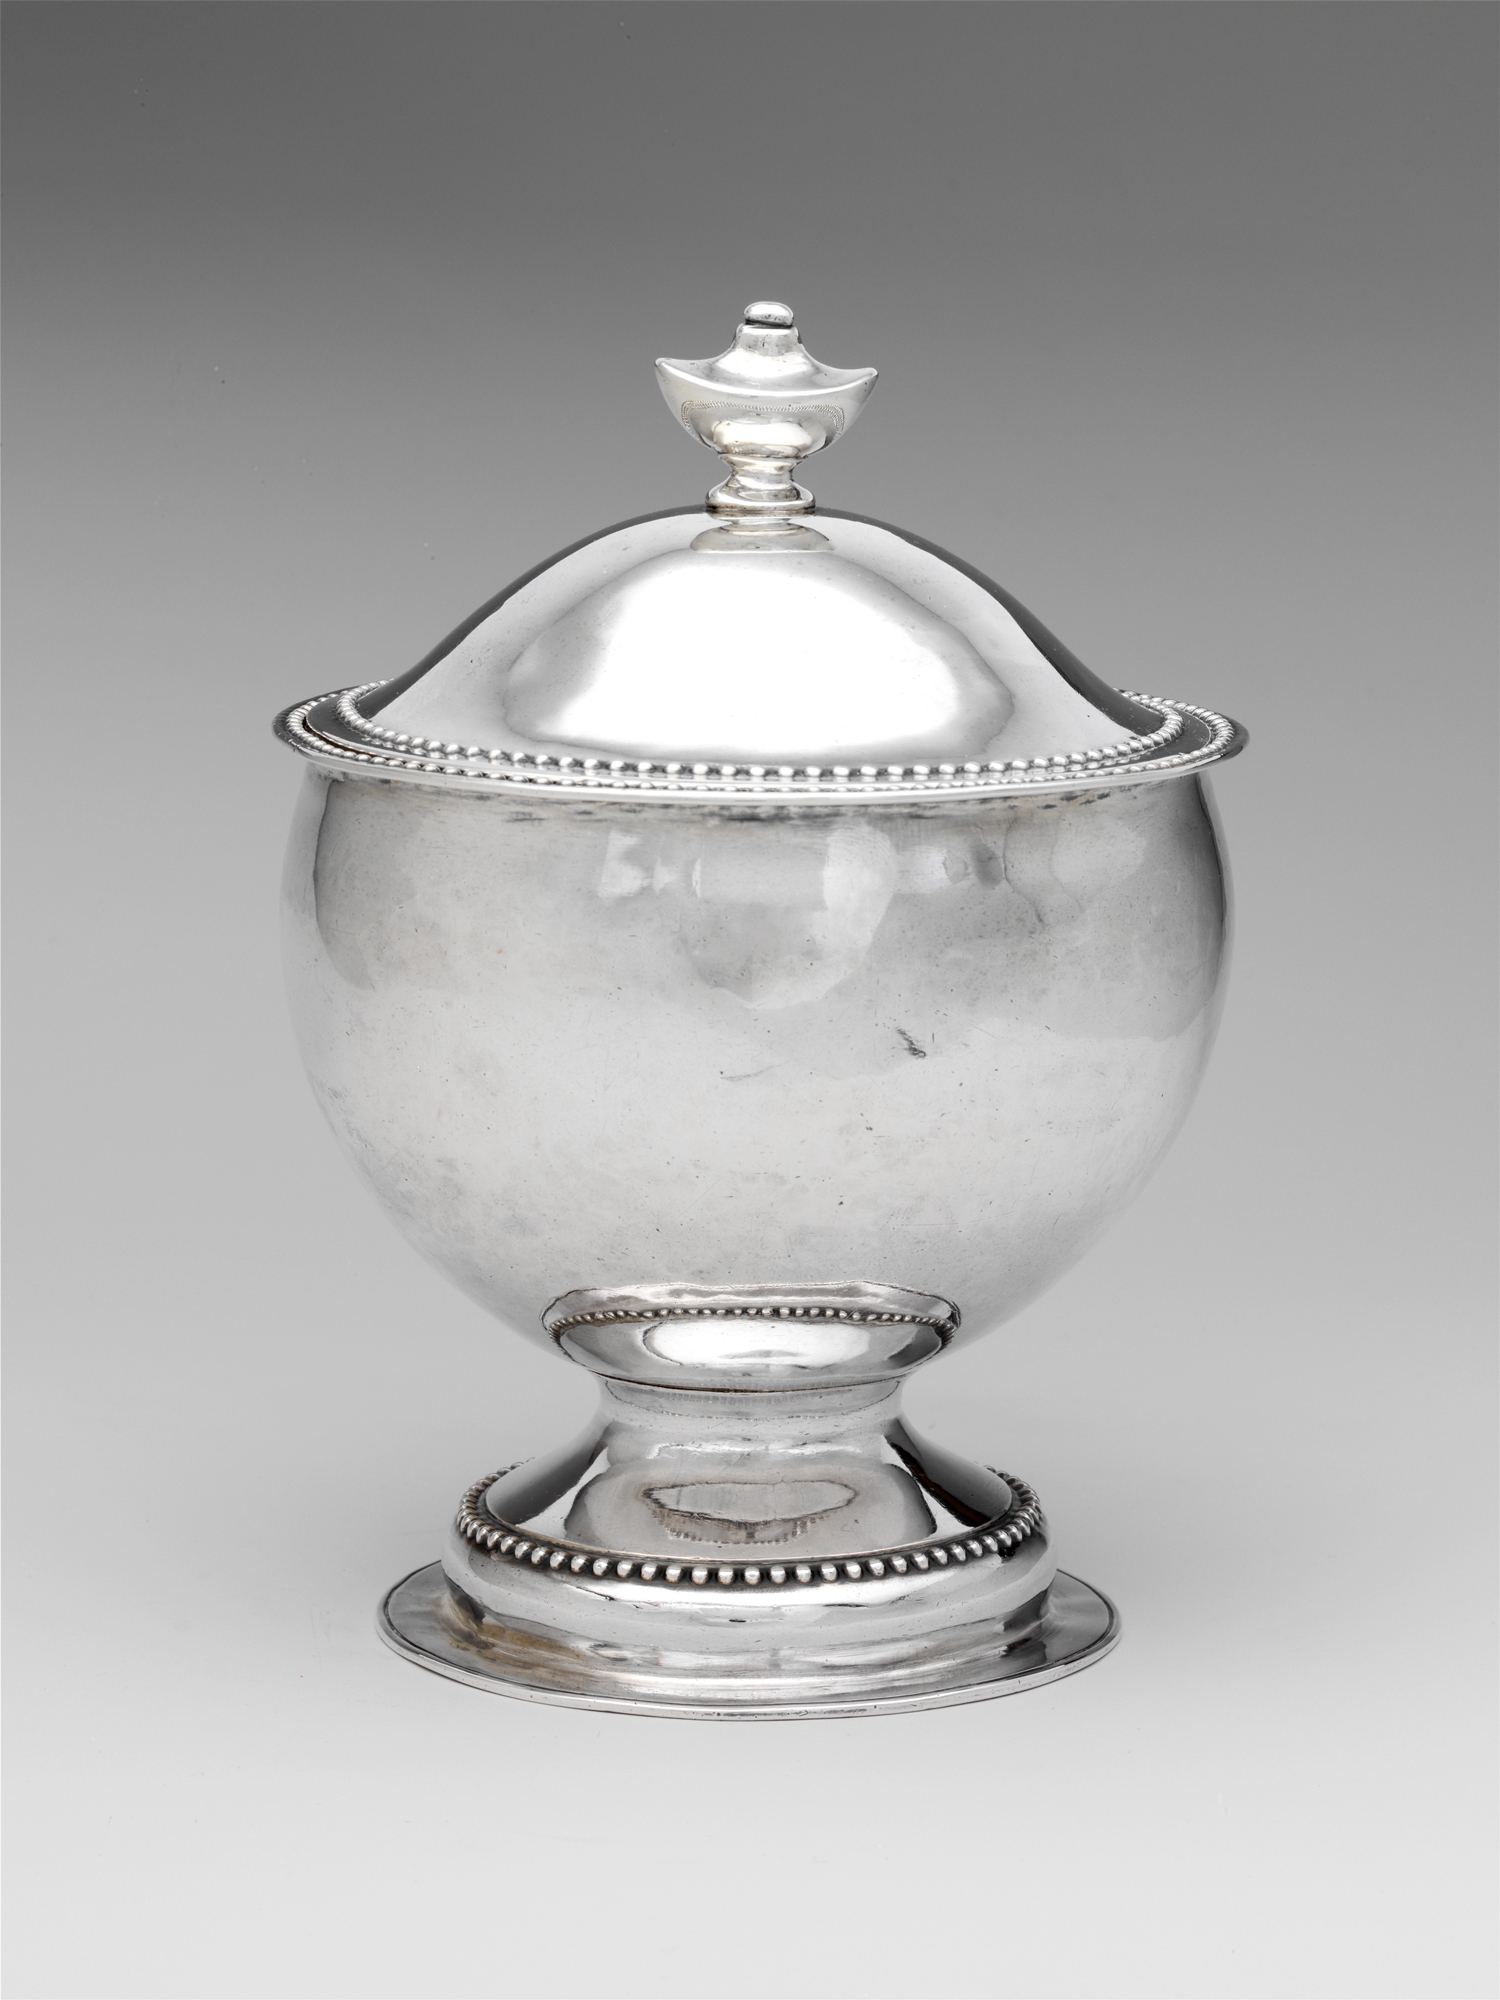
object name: sugar bowl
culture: american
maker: david vinton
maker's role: maker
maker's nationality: american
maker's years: 1774-1833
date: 1795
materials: silver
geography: united states